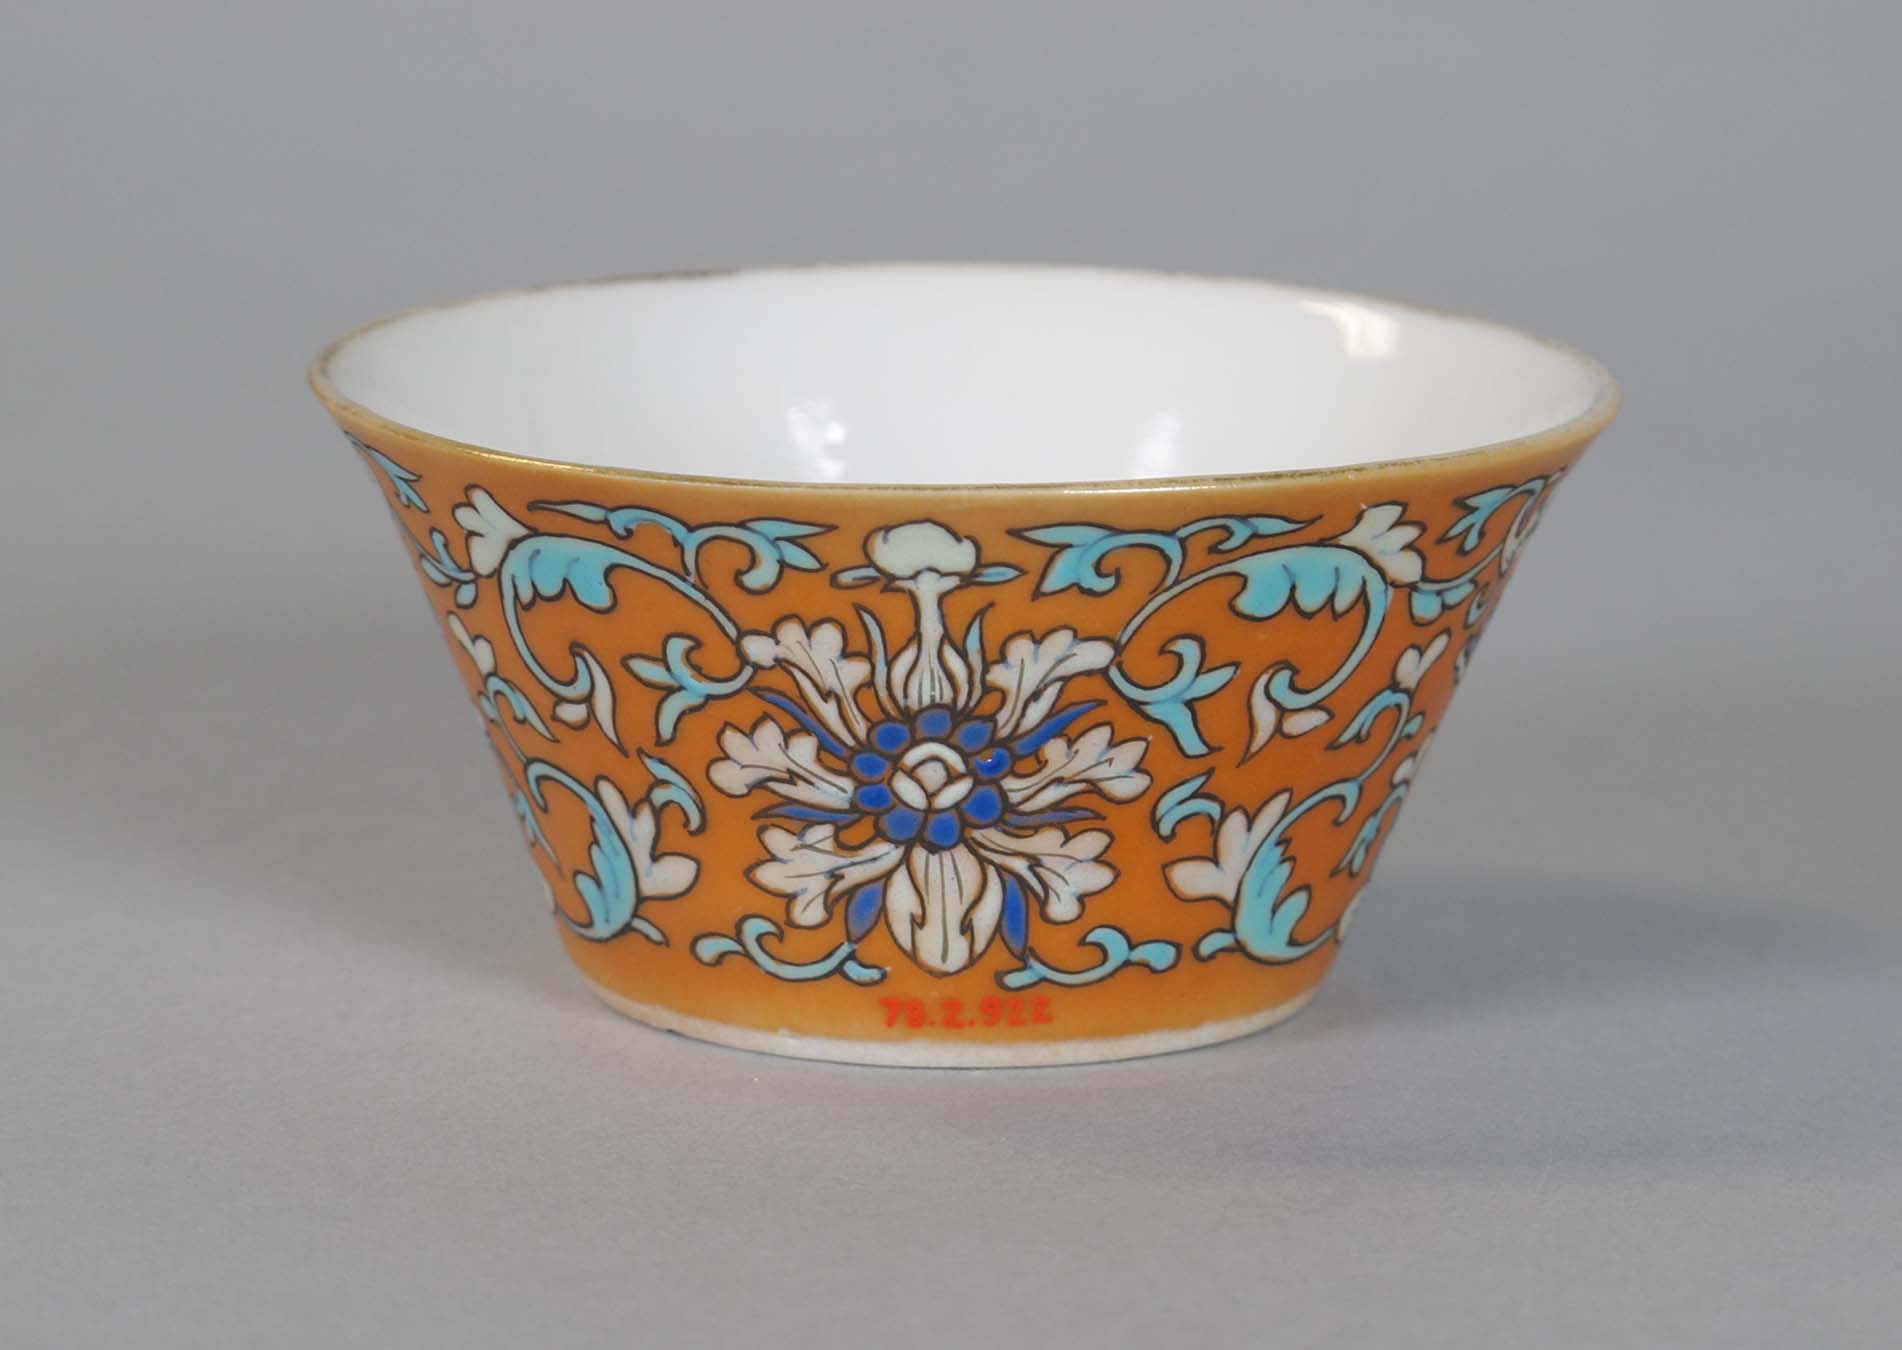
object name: cup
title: Cup (from a set of eight)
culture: chinese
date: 1644-1911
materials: enamel, glaze, iron, porcelain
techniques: overglaze, painting, polychrome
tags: flowers